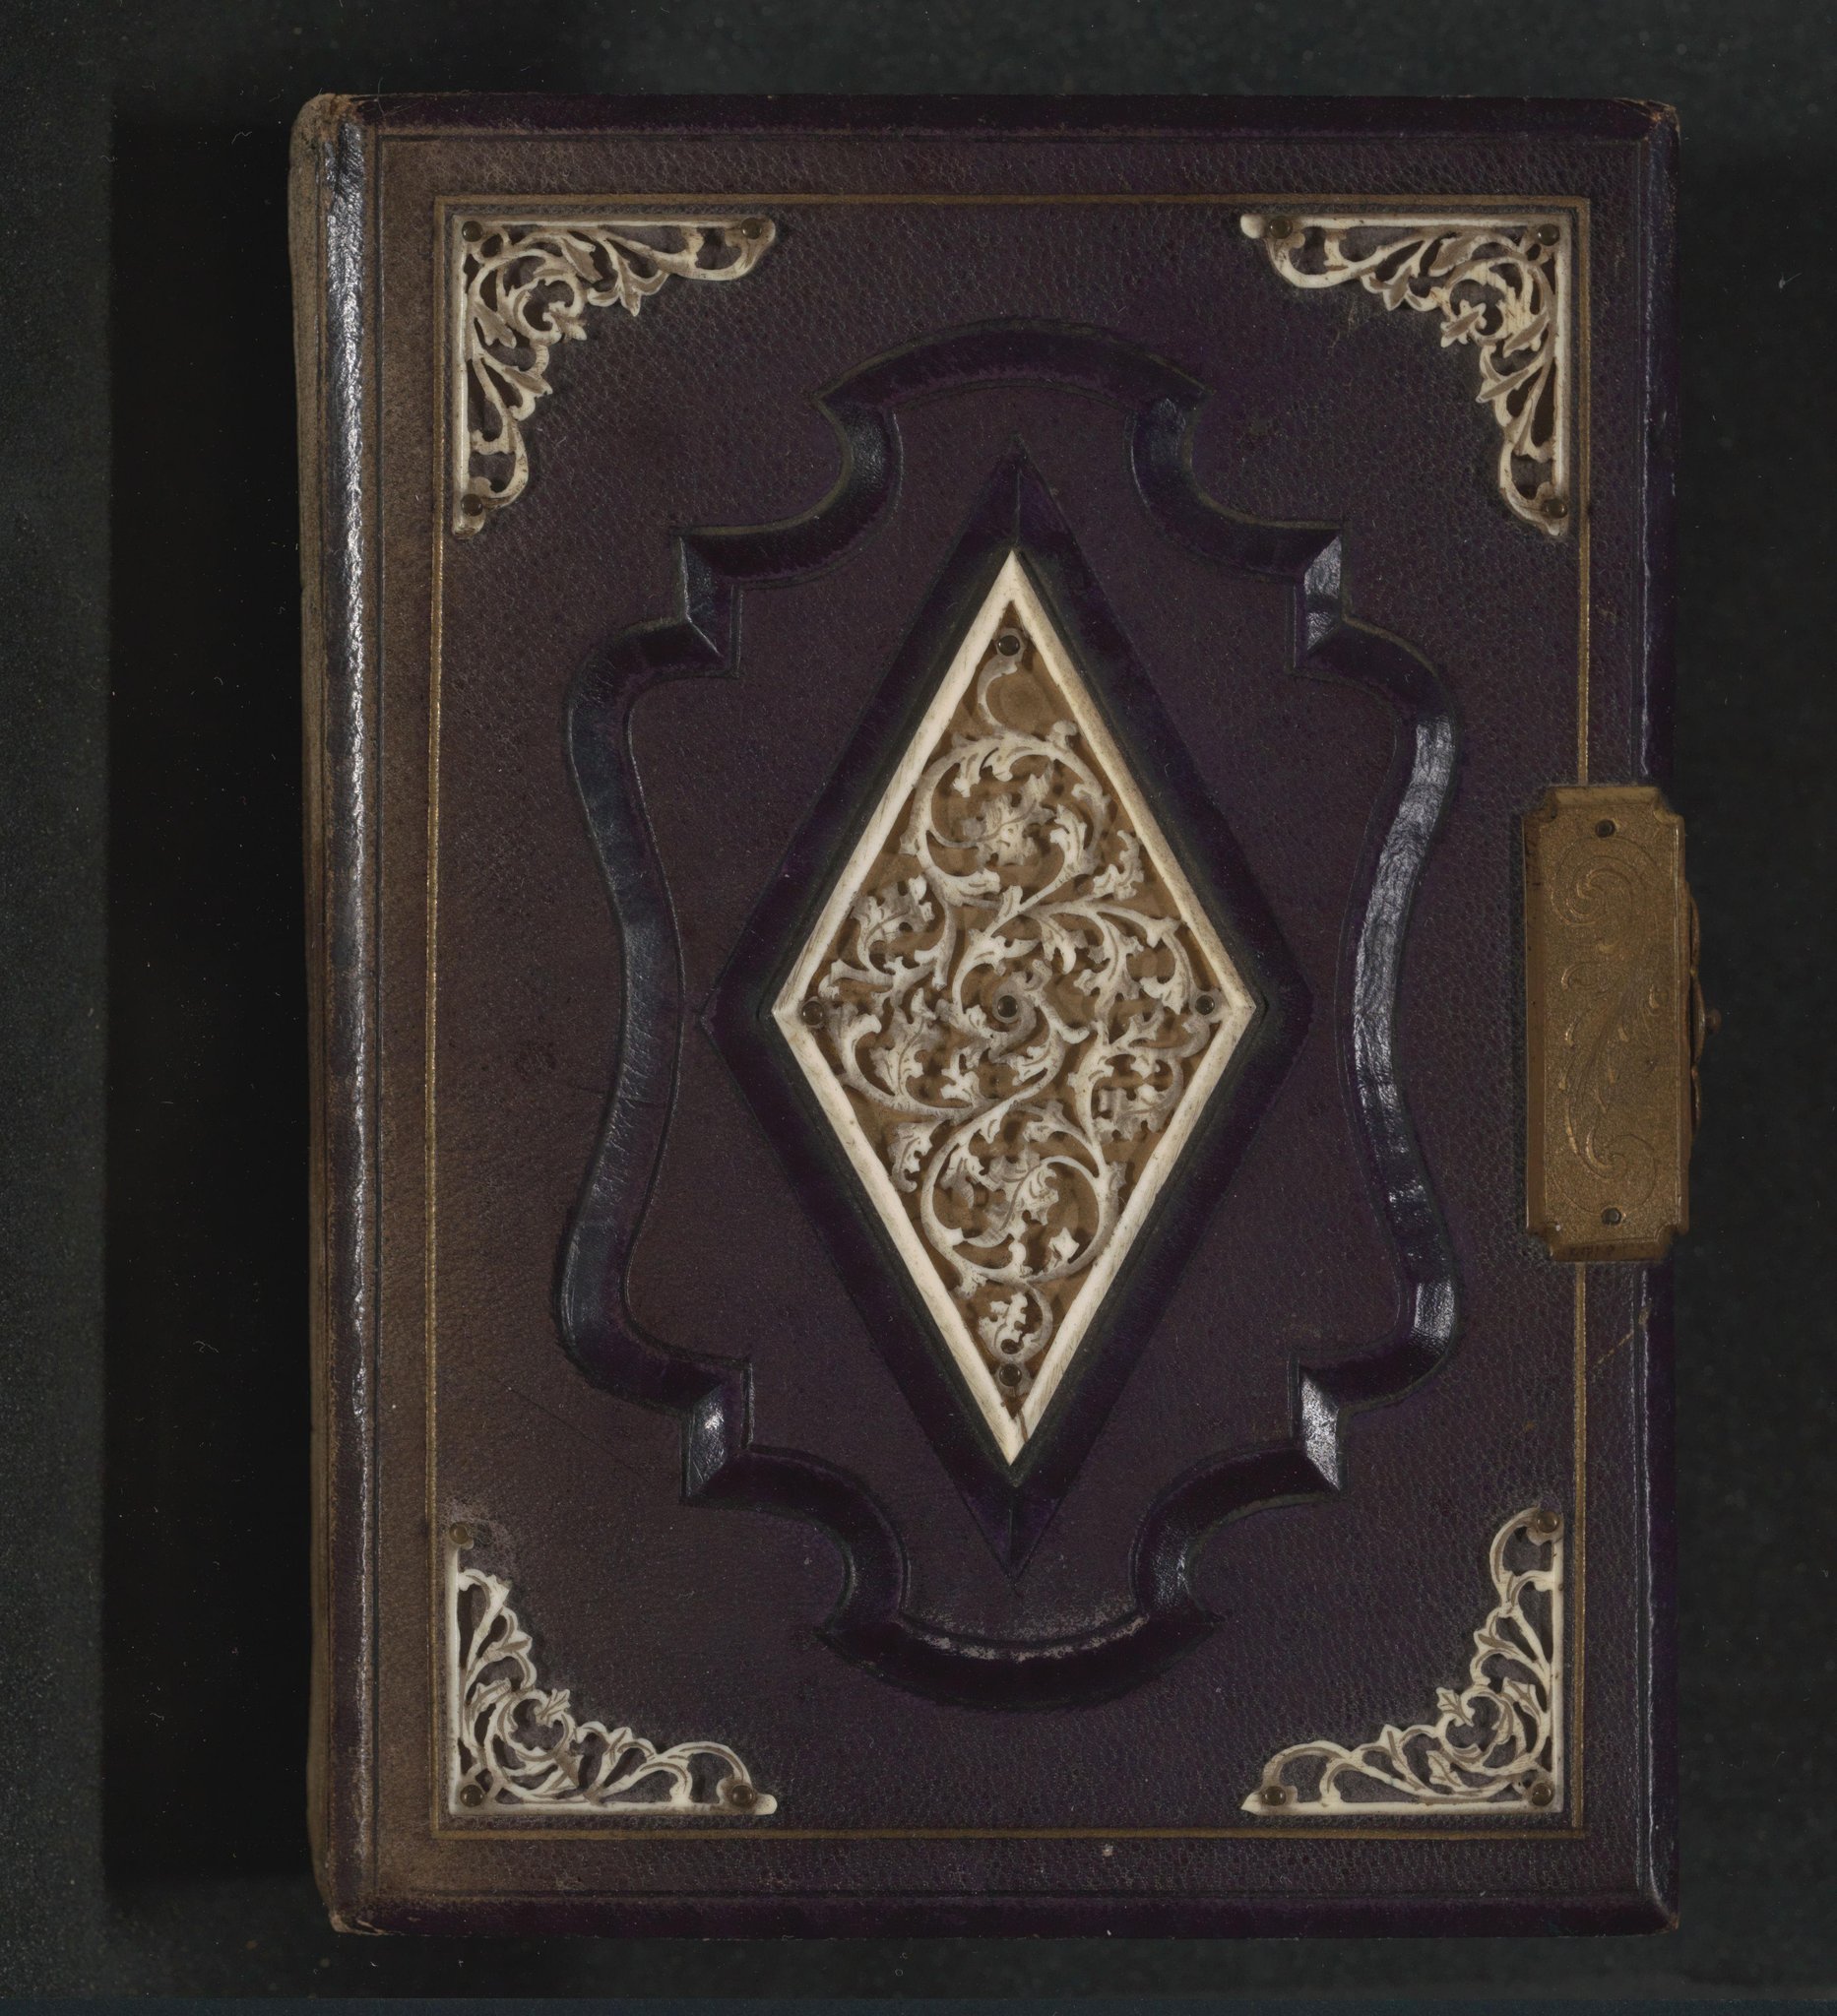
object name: photograph album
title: Fotoalbum met 36 opnames van Europese landen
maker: Anonymous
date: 1860-1890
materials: bone, cardboard, copper, glass, leather, paper, photographic support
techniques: albumen print, chromolithography, photograph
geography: europe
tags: landscapes, travelling; tourism, prospect of city, town panorama, silhouette of city, dog, netherlands, italy, germany, switzerland, belgium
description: Fotoalbum in bruine omslag met koperen slot. Voor- en achterzijde zijn versierd met een wapenschild in reliëf. De voorzijde is tevens verfraaid met benen snijwerk en (vermoedelijk) glazen kralen. De schutbladen zijn van changeant papier. Het album bevat 19 albumbladen met goud op snee. Het betreft 36 opnames van bezienswaardigheden in België, Zwitserland, Duitsland, Italië en Nederland. Ook een serie studiofoto's van honden.